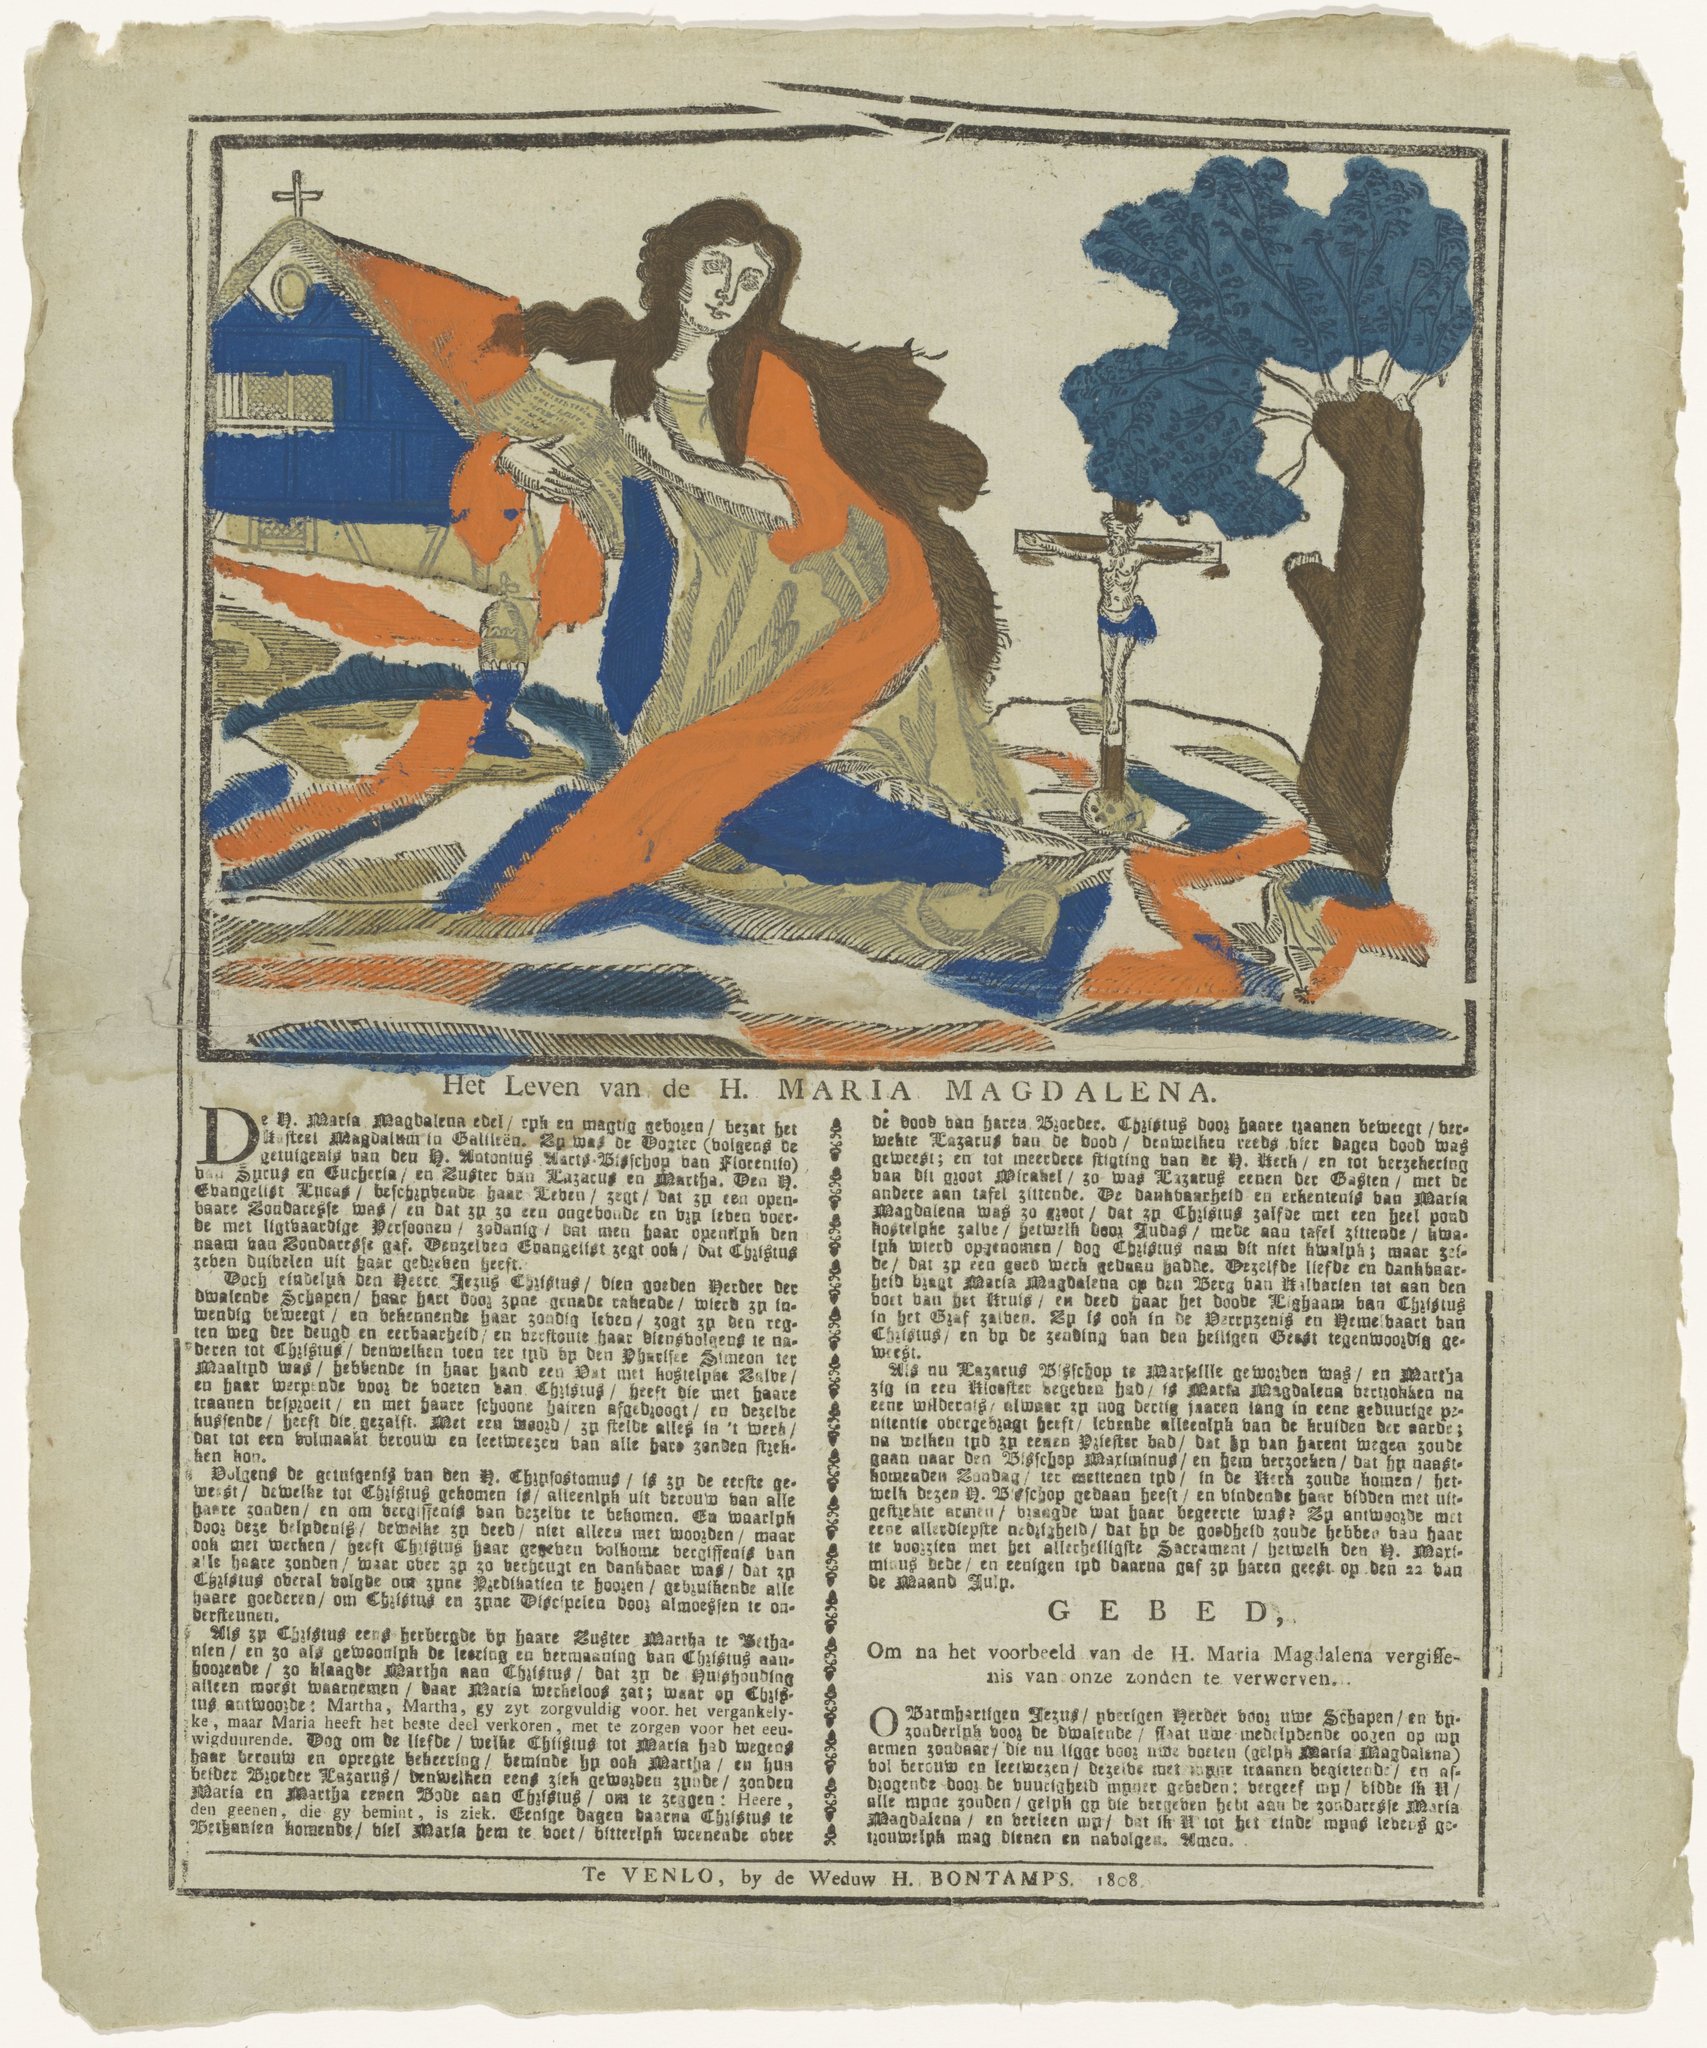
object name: print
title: Het leven van de H. Maria Magdelena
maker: weduwe h. bontamps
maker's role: publisher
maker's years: -1817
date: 1808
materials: paper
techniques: hand coloring, letterpress printing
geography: venlo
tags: the penitent harlot mary magdalene; possible attributes: book (or scroll), crown, crown of thorns, crucifix, jar of ointment, mirror, musical instrument, palm-branch, rosary, scourge - specific aspects ~ female saint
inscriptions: collector's mark: Lugt 2228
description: Blad met een grote voorstelling van de boetvaardige Maria Magdalena in een landschap. In haar handen een opengeslagen boek, naast haar een zalfpot en een crucifix. Op de achtergrond een kerk. In de ondermarge een Bijbeltekst en gebed in twee kolommen.